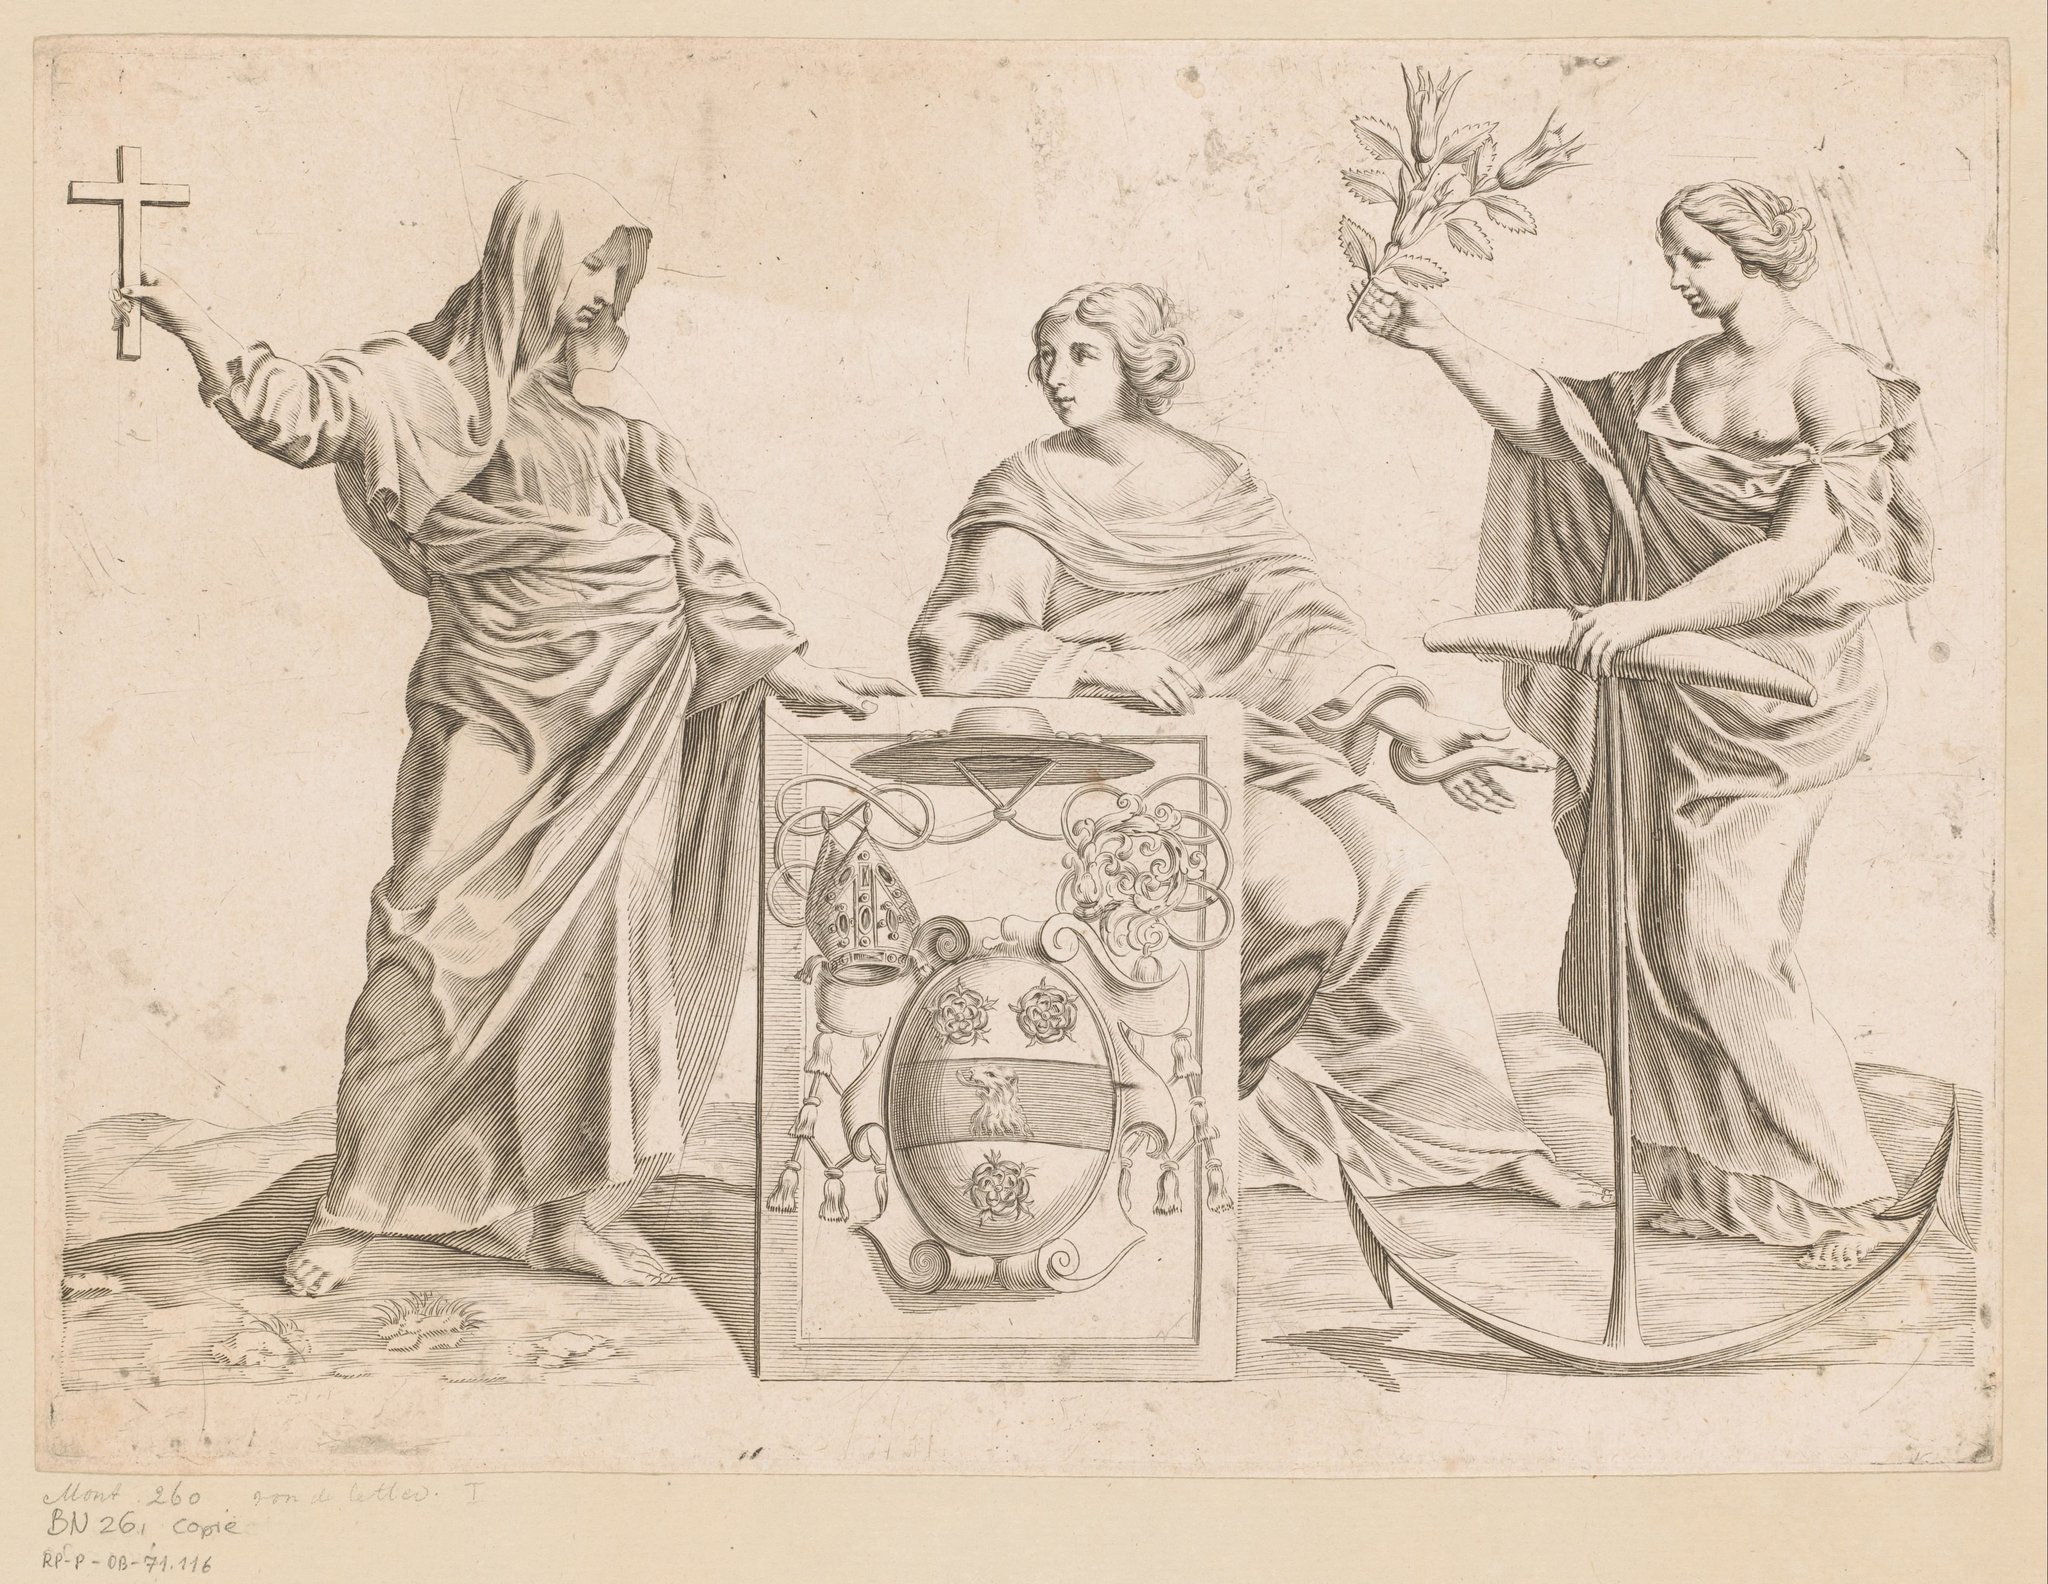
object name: print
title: Religie, Minerva en Vrede bij wapen van Claude Auvery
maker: Anonymous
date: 1608-1688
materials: paper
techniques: engraving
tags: symbols, allegories of peace, 'pax'; 'pace' (ripa), (story of) minerva (pallas, athena)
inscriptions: collector's mark: Lugt 240